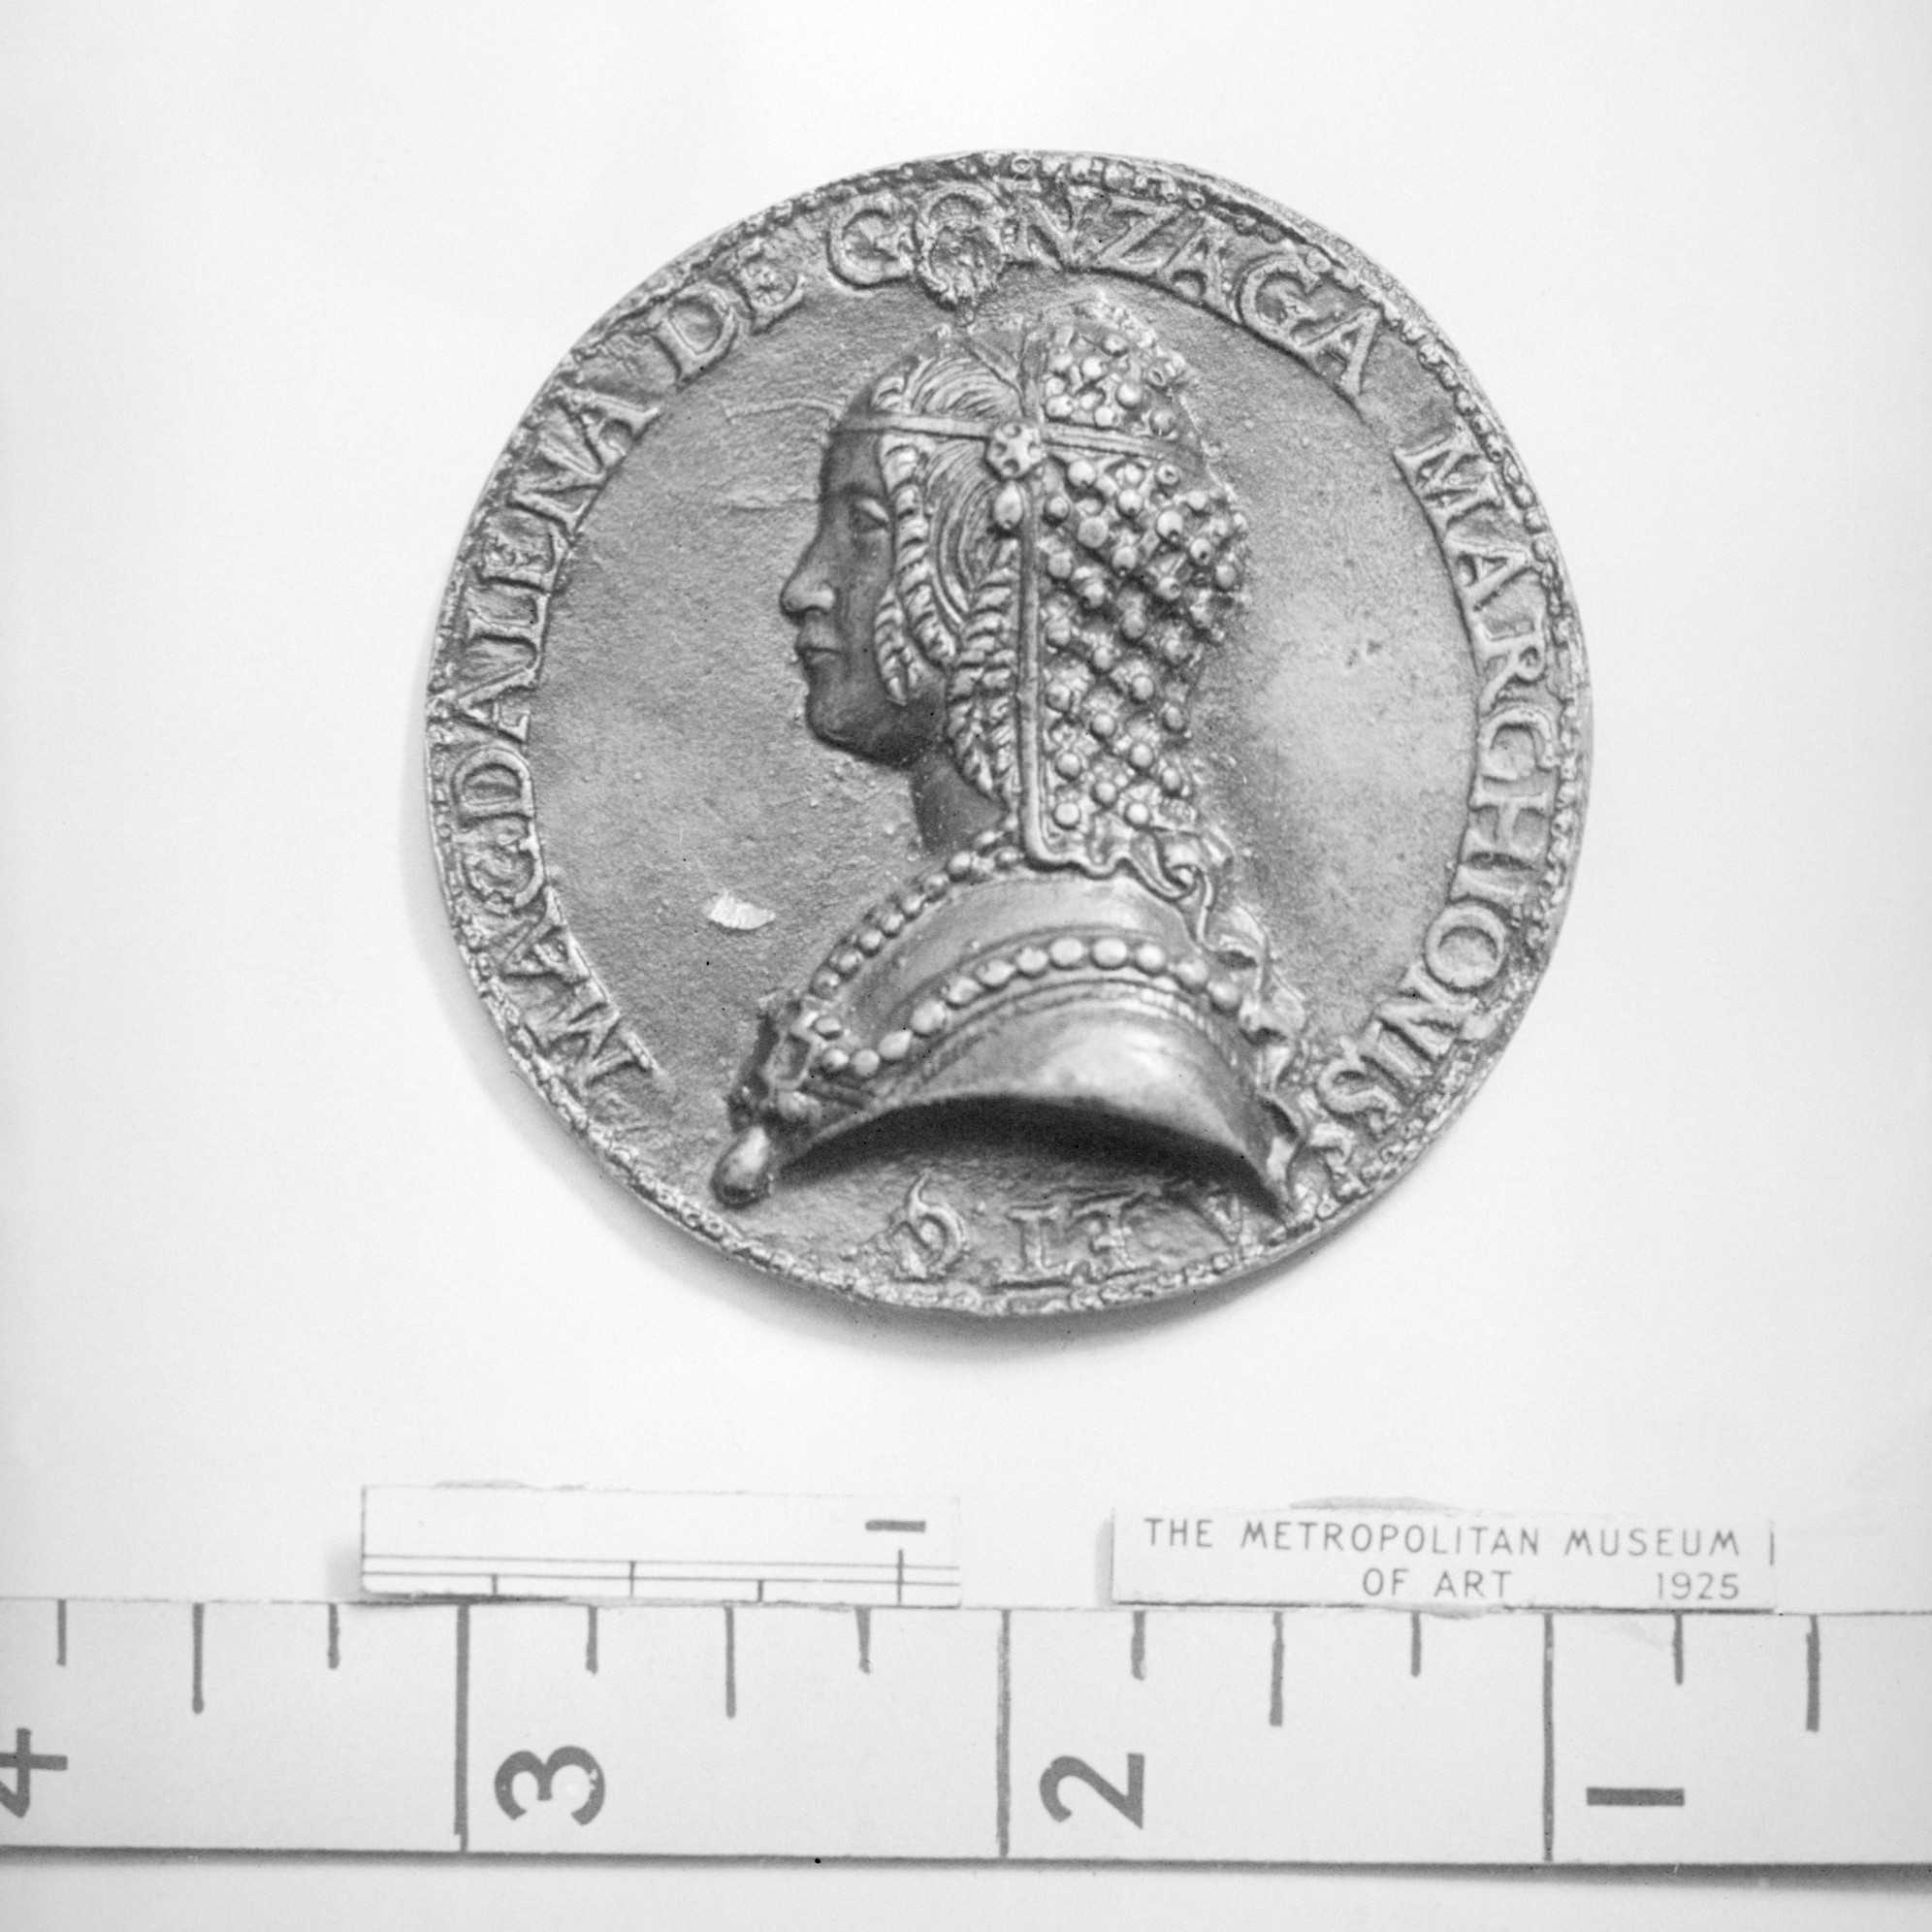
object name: medal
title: Magdalena Gonzaga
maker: bartolommeo melioli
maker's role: artist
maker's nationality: italian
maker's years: 1448-1514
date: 1401-1500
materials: bronze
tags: profiles,women